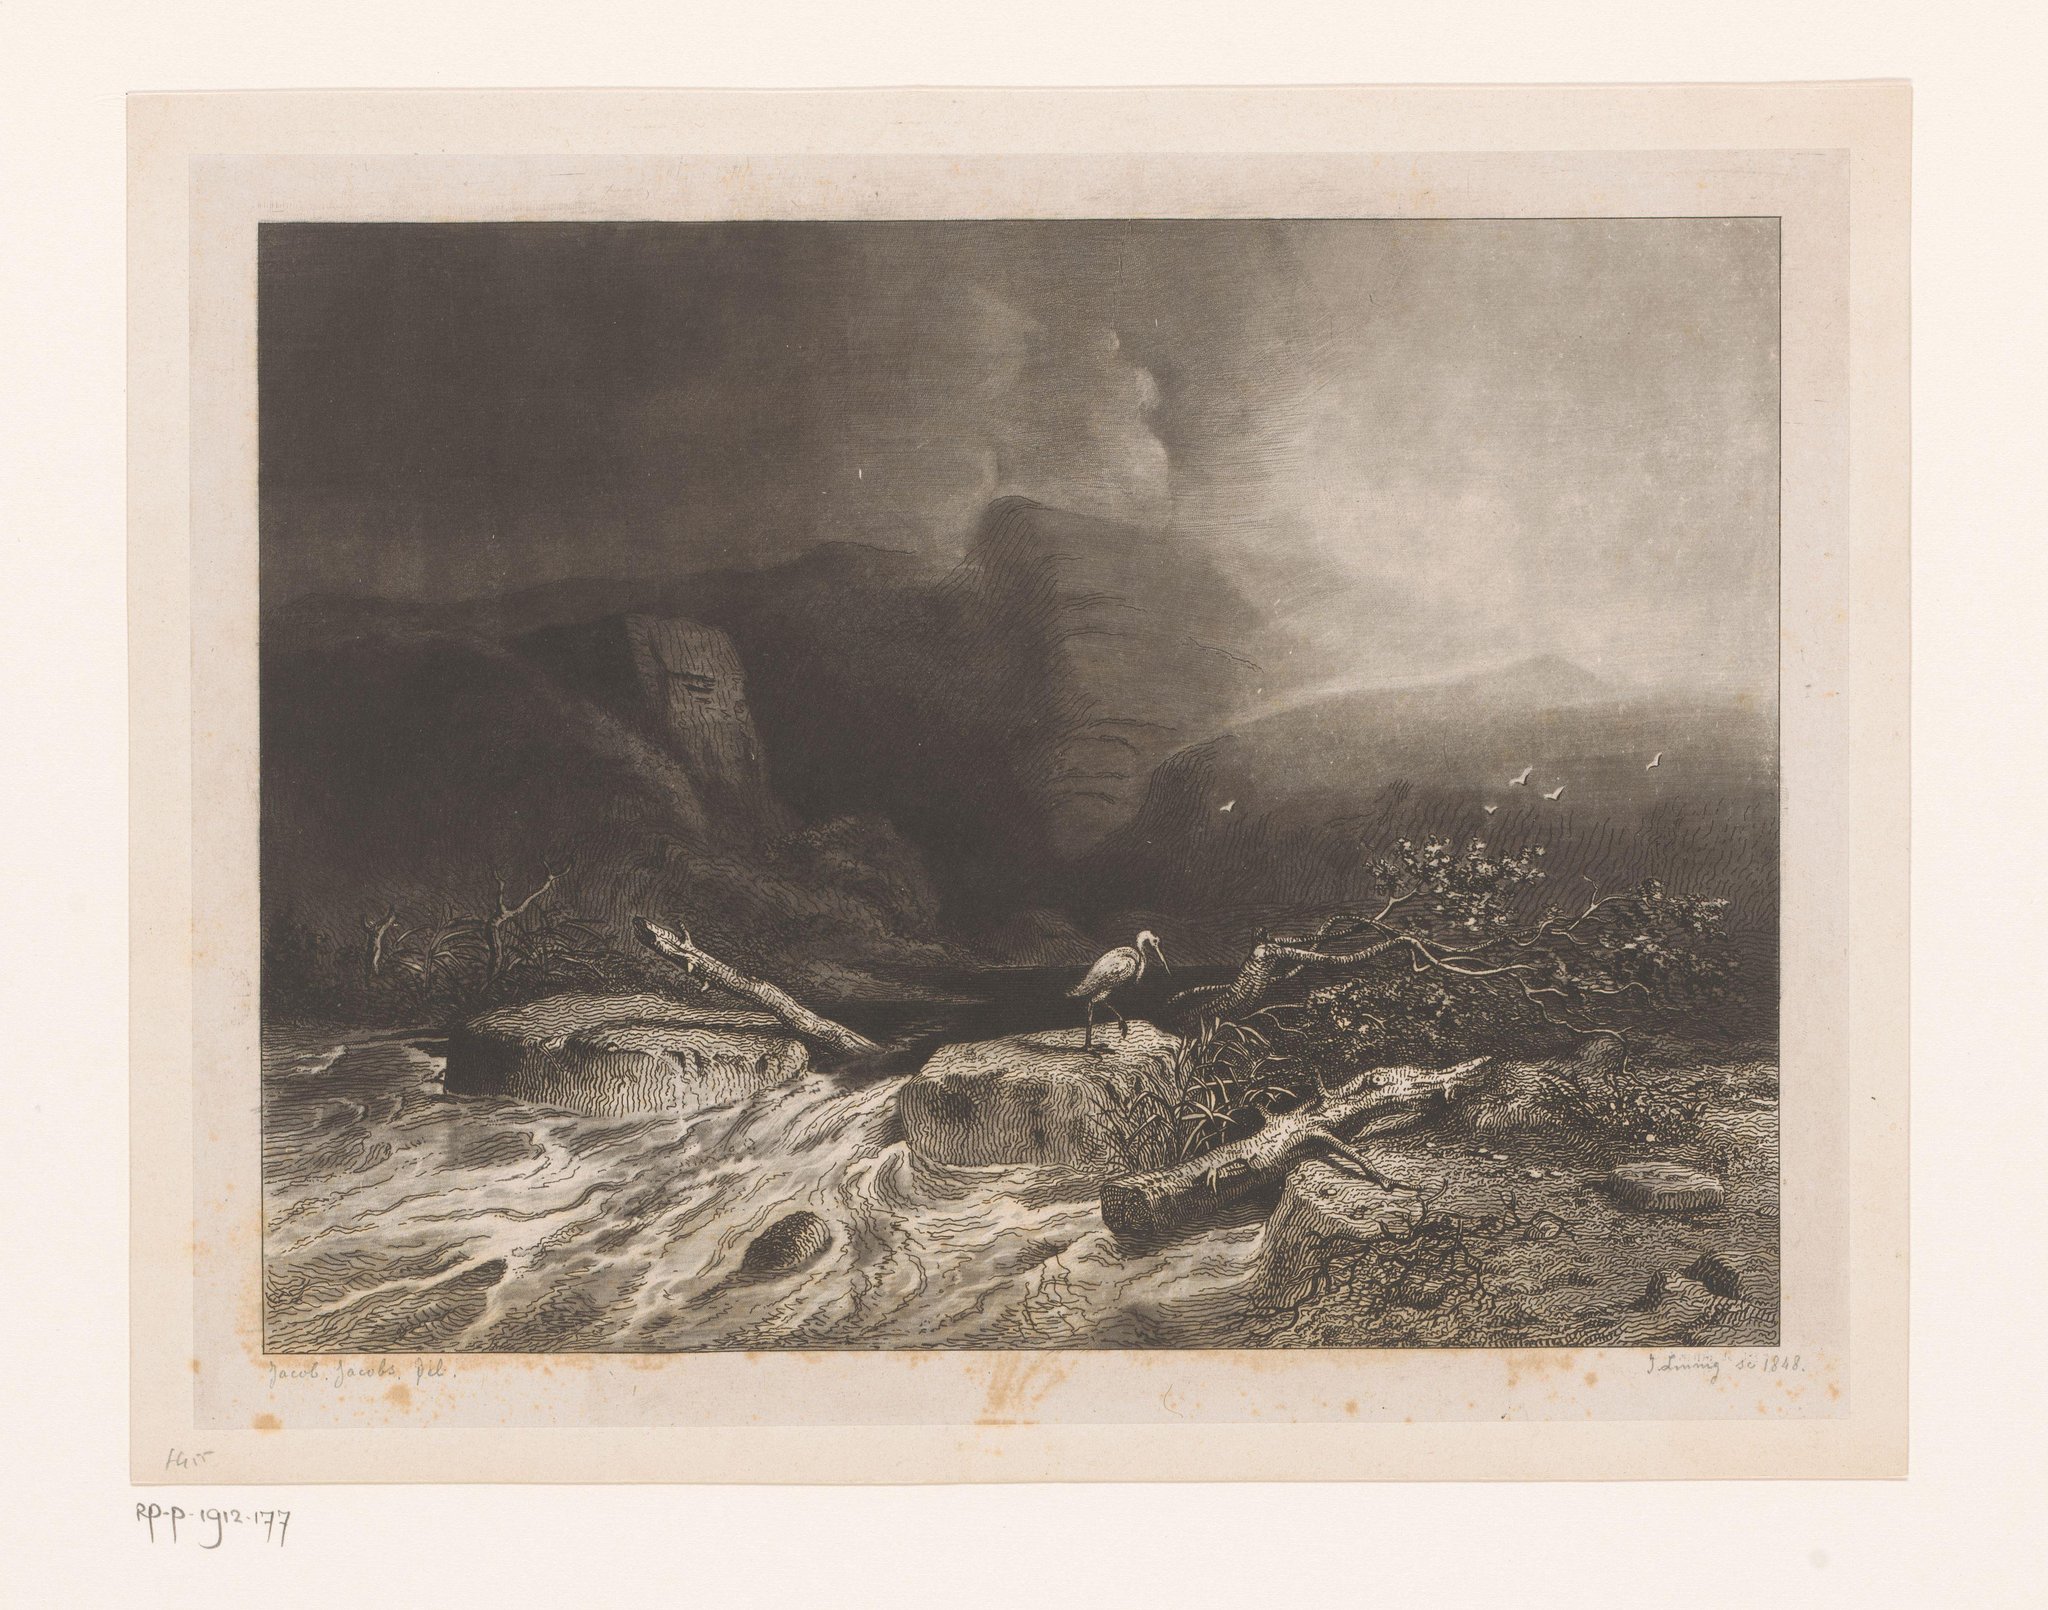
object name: print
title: Rotsachtig landschap met rivier en reiger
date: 1848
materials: paper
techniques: etching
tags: river, shore-birds and wading-birds: heron, boulder, stone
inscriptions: collector's mark: Lugt 2228